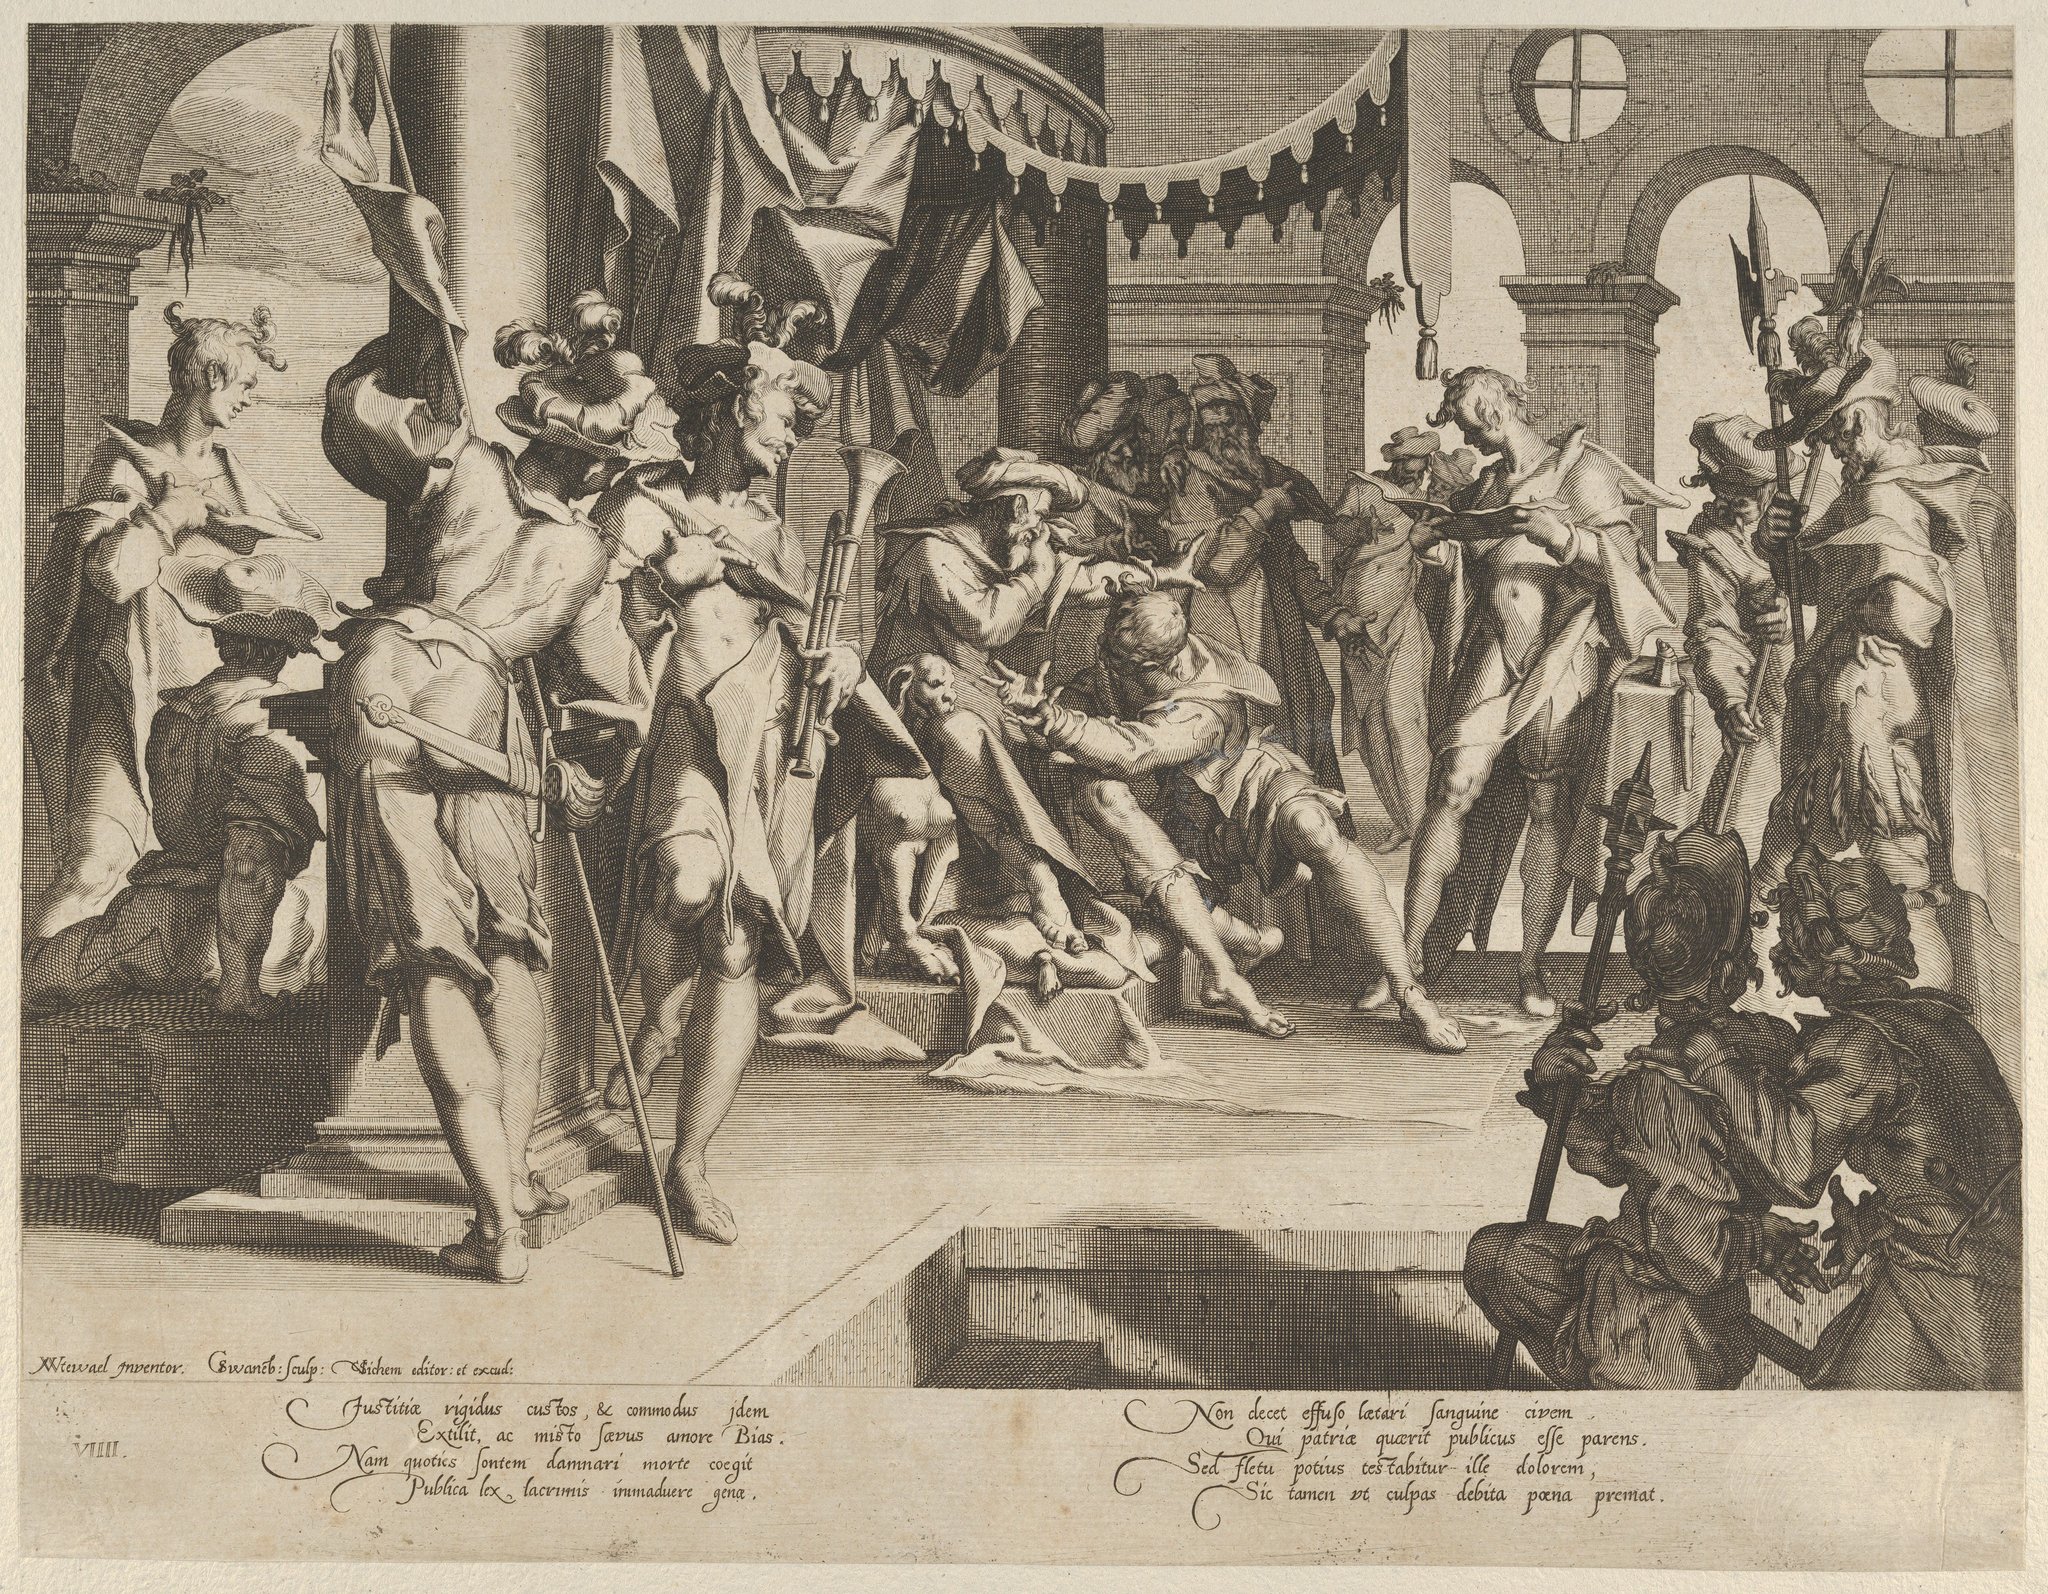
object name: print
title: The Judge Bias Shedding Tears, plate 9 from "Thronus Justitiae, tredecim pulcherrimus tabulis..."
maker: willem van swanenburg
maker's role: artist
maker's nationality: netherlandish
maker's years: 1581-1612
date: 1605-1606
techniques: engraving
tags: musical instruments,weapons,men,women